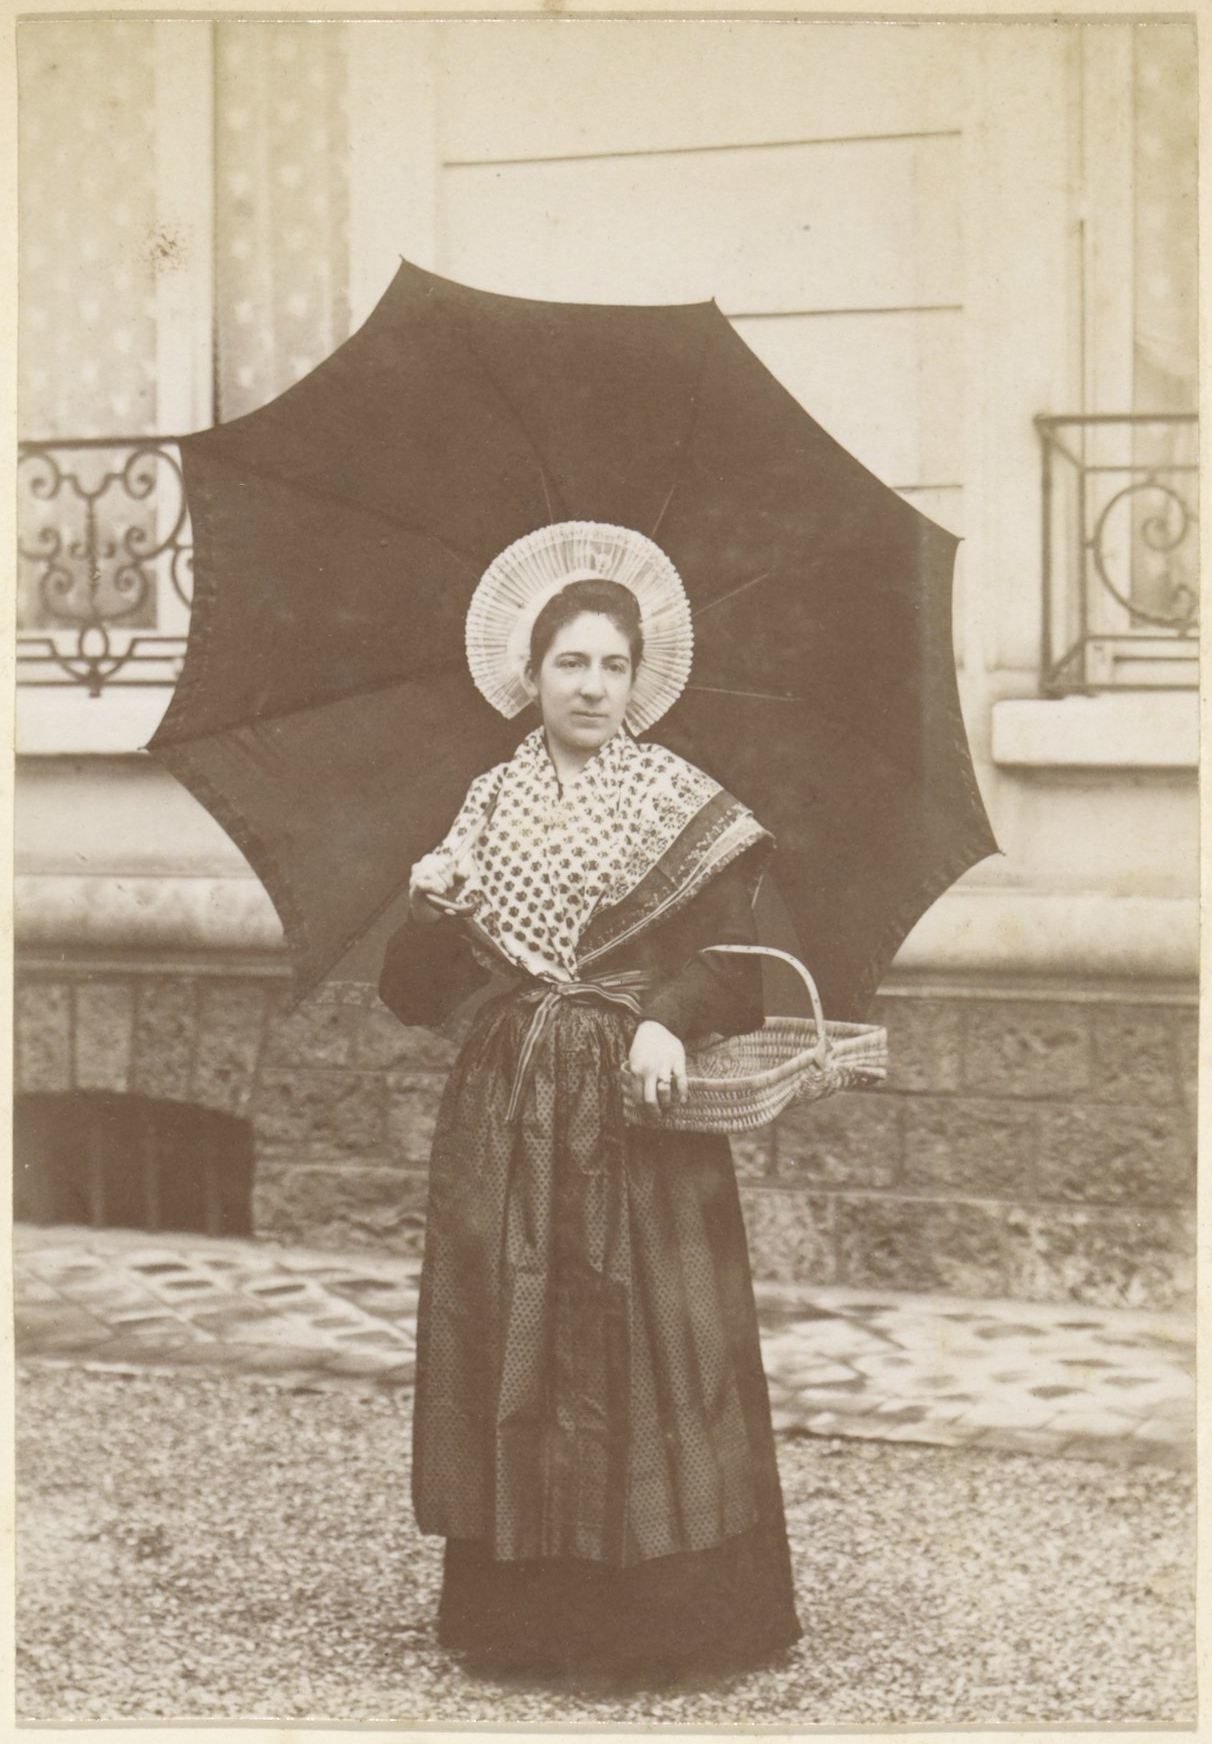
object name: photograph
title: Portret van een Franse vrouw in traditionele kledij met omslagdoek, mand en paraplu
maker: Anonymous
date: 1900-1910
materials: paper, photographic support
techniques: albumen print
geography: france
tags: folk costume, regional costume (+ women's clothes), adult woman, umbrella, france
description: Onderdeel van Fotoalbum van een Franse amateurfotograaf met opnames van een familie, distilleerderij Delizy & Doistau Fils, het leger en bezienswaardigheden in Frankrijk.